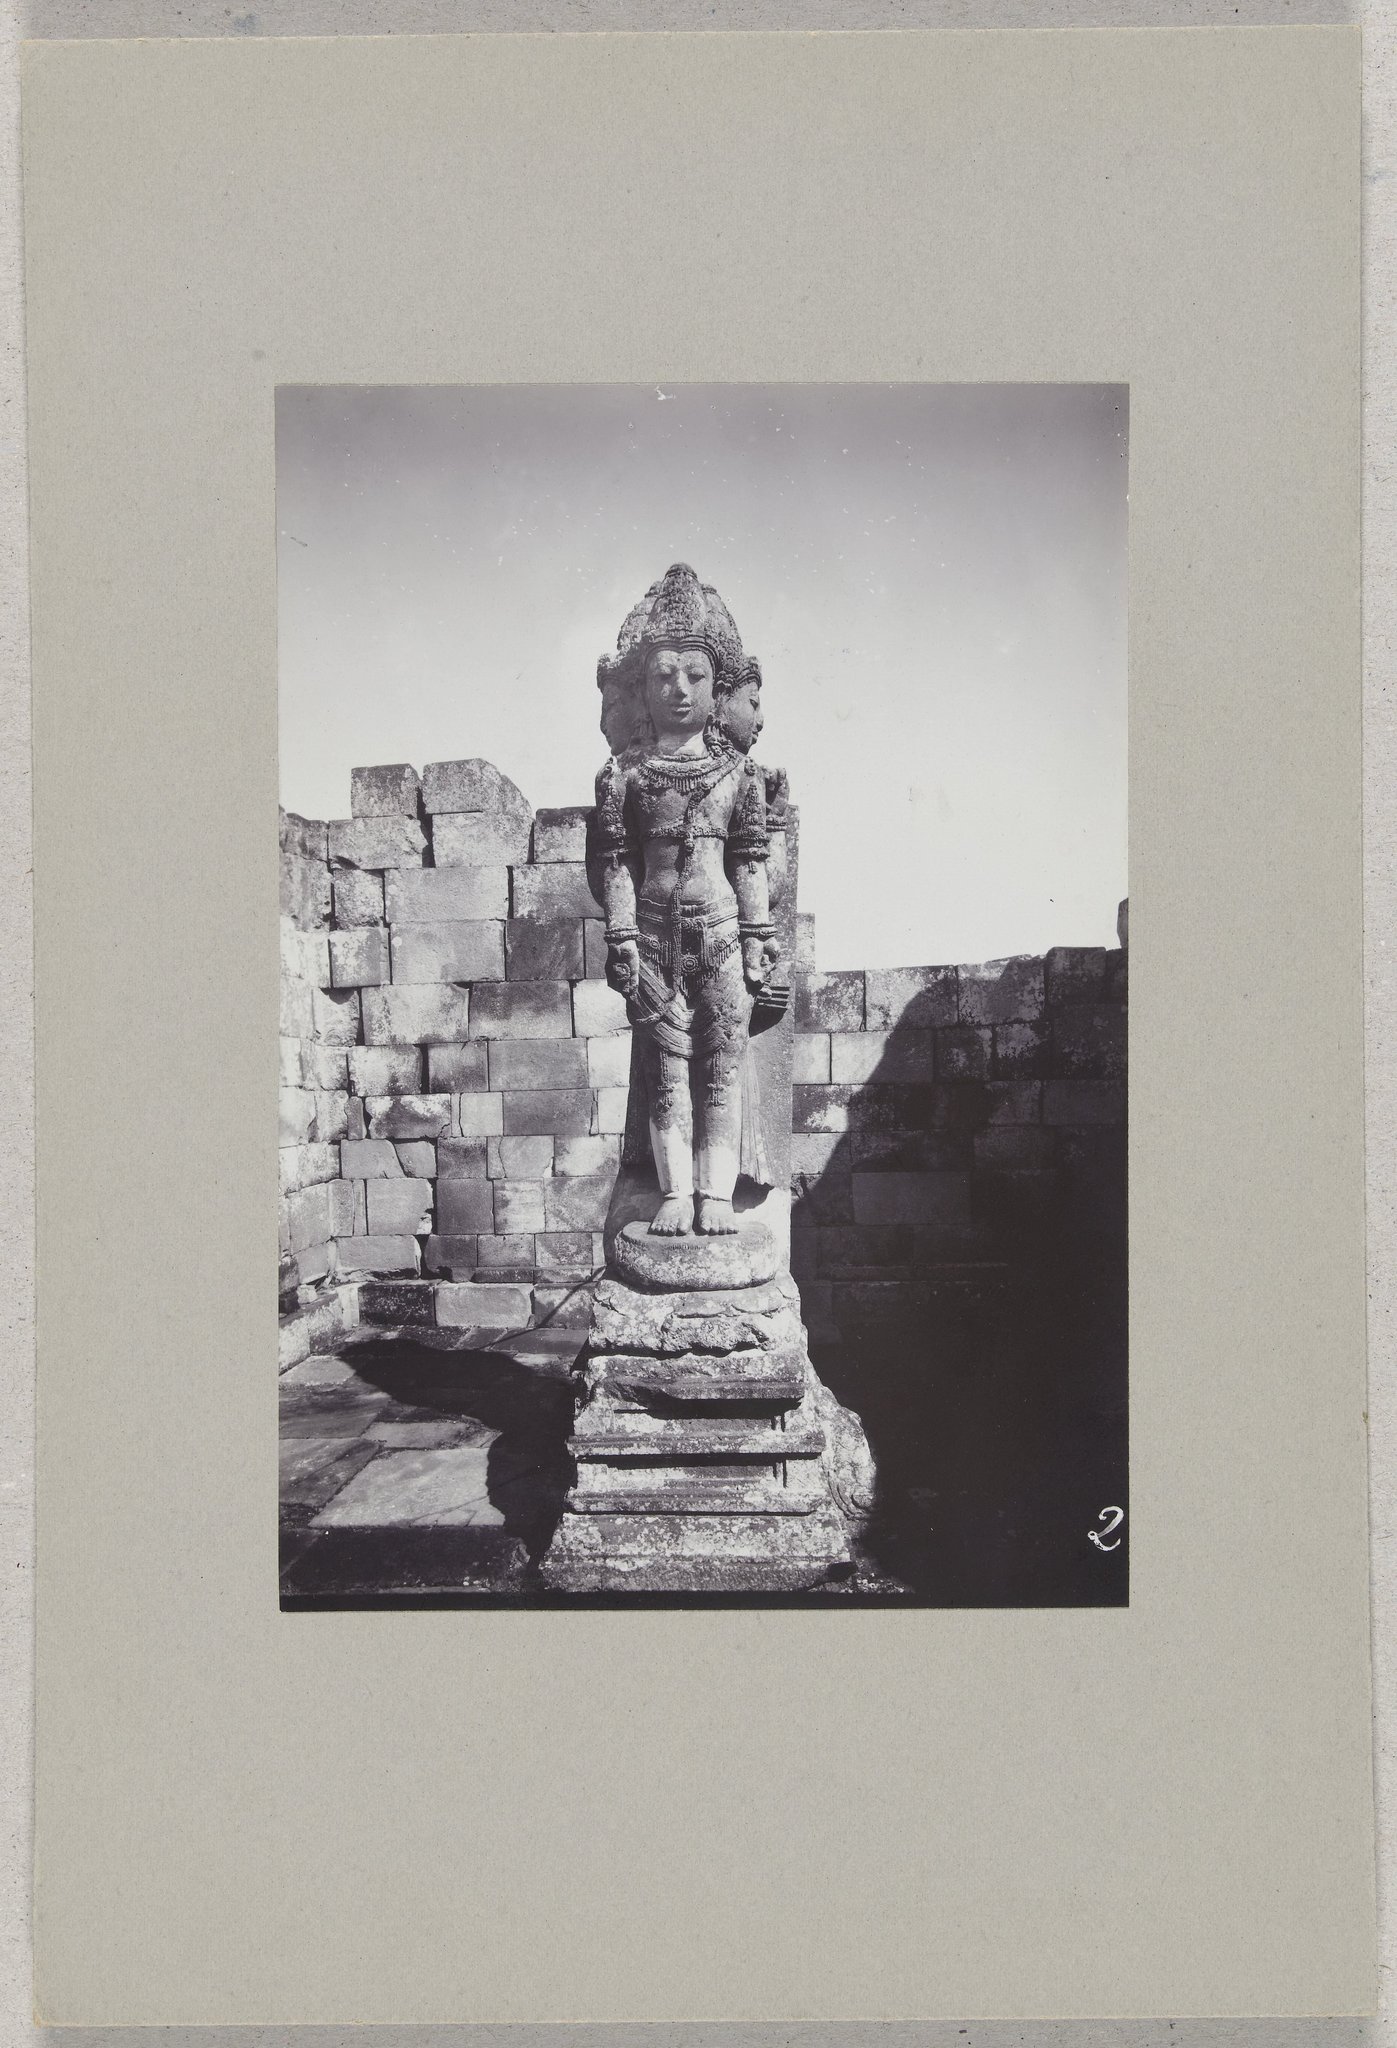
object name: photograph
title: Beeld in een tempel van Prambanan bij Jogyakarta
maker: Anonymous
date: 1895-1915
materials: cardboard, paper, photographic support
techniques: gelatin silver print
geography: jogjakarta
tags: indonesia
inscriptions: annotation: ‘87a Beeld in tempel c’, number: ‘2’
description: Beeld in een tempel van Prambanan bij Jogyakarta, Nederlands-Indië